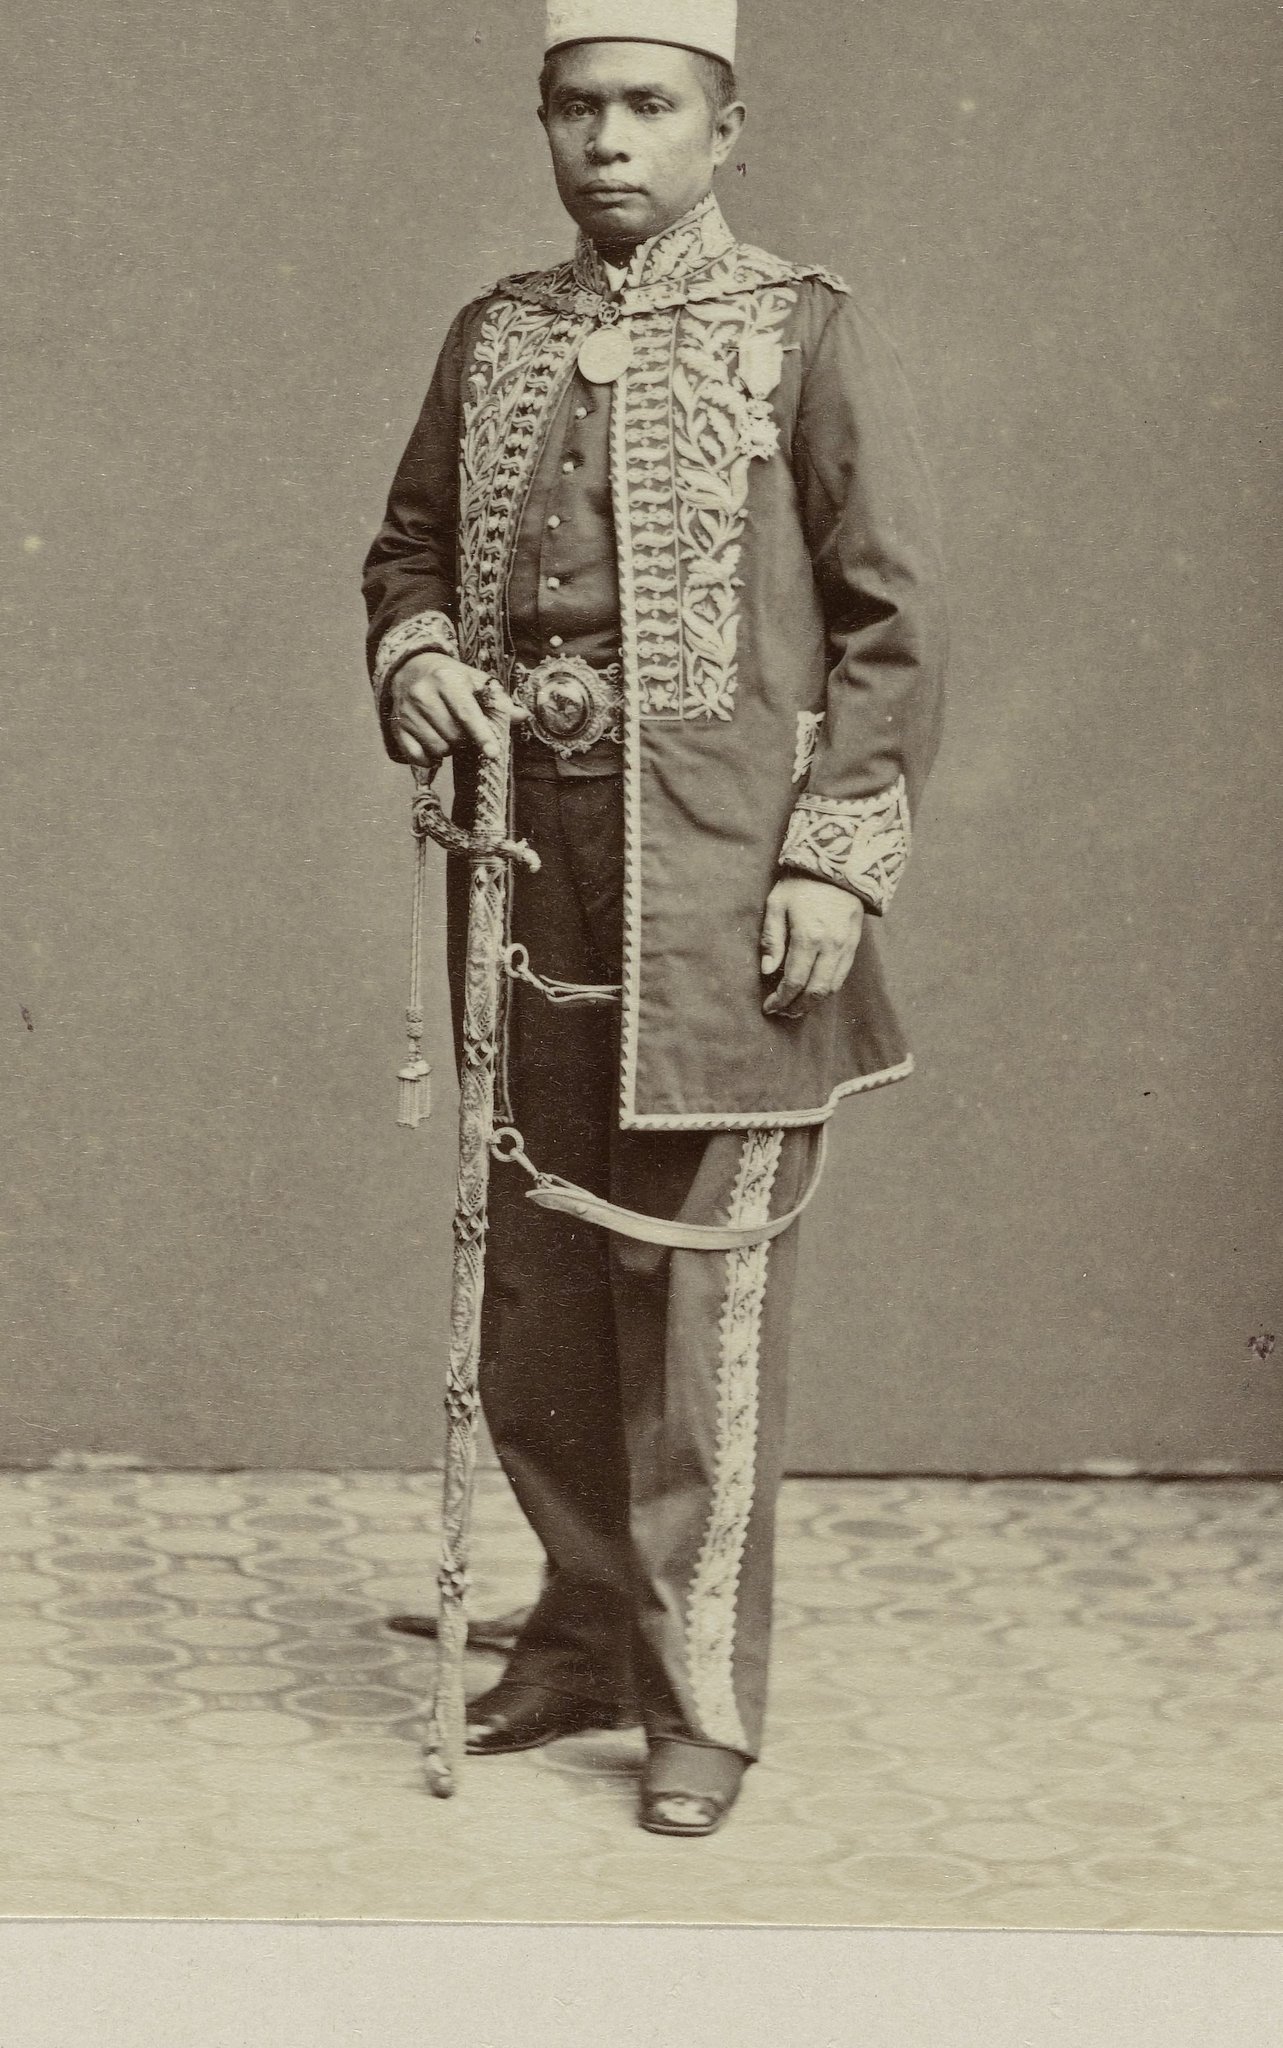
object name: photograph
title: Jonge Javaanse vorst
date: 1865-1890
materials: photographic support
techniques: albumen print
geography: batavia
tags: ruler, sovereign, historical persons not known by name, java, batavia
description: Studioportret van een jonge Javaanse vorst met zwaard. Ingeplakte foto in het fotoalbum getiteld: Gezichten van Java.